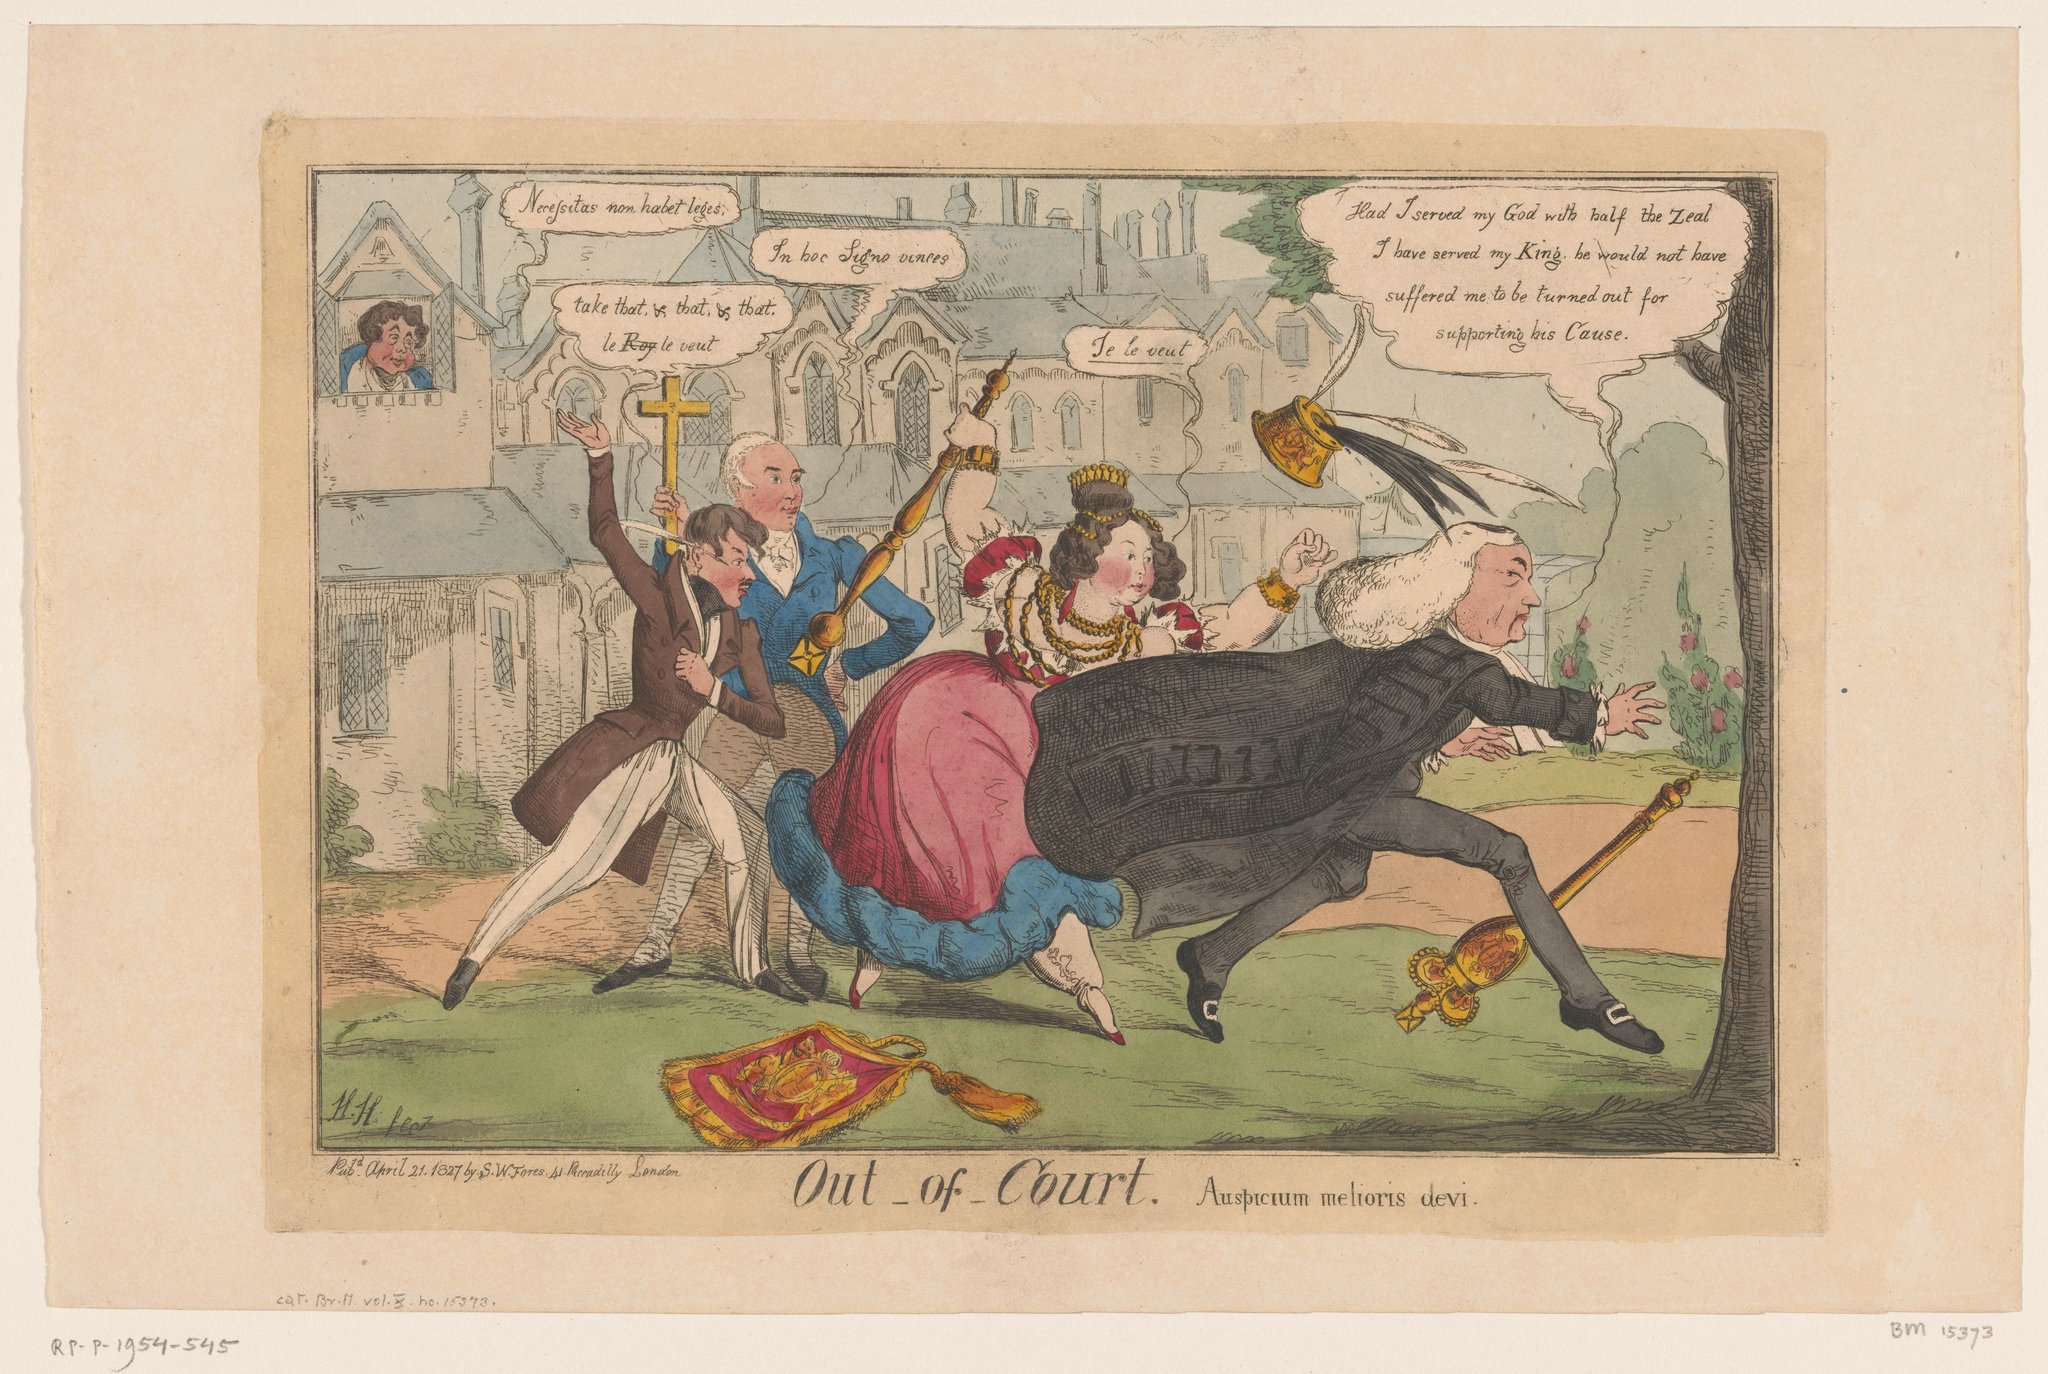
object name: cartoon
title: Out-of-court. Auspicium melioris ævi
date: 1827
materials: paper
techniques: etching, hand coloring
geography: england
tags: politician, george iv (koning van het verenigd koninkrijk), london, protestant churches and denominations, roman catholic church, political caricatures and satires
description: Spotprent op de spanningen in het Britse kabinet tussen de Protestanten en Katholieken in maart en april 1827. Lord Chancellor Eldon, vertegenwoordiger van de protestanten, wordt verjaagd door Lady Conyngham, maitresse van de koning. In zijn vlucht laat Eldon de Mace en de Purse of the Great Seal vallen. De katholieke Canning kijkt met kruis in de hand tevreden toe. Vanuit de zolderraam van een huis kijkt koning George IV toe.